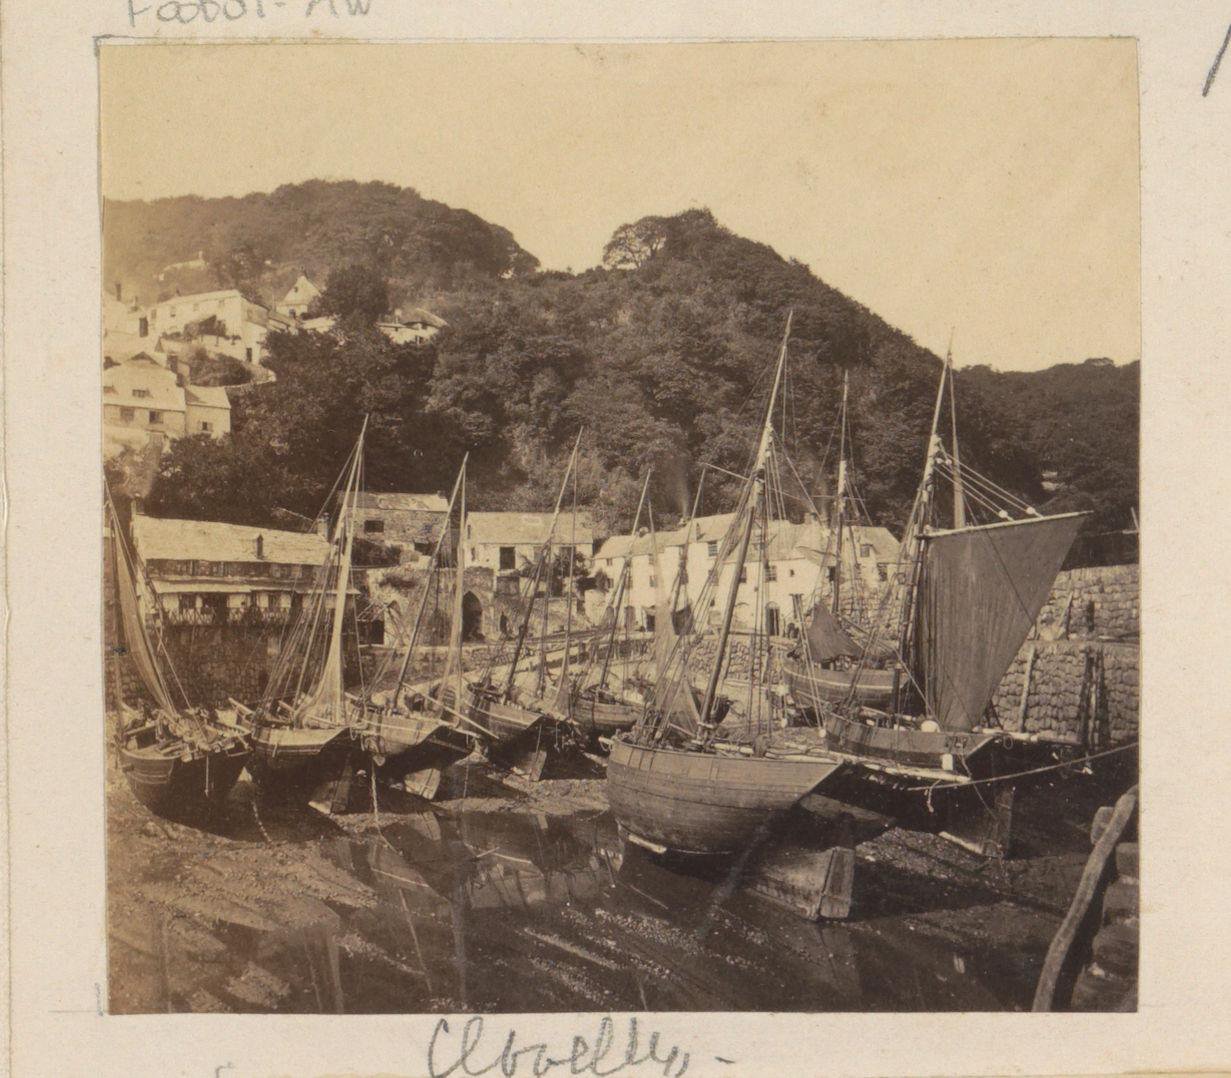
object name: photograph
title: Drooggevallen schepen in de haven van Clovelly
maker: Anonymous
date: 1850-1870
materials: paper, photographic support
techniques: albumen print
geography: clovelly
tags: harbour, ships, boats on land, beached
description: Onderdeel van Album met foto's van bezienswaardigheden en landschappen in Engeland en van kunst.